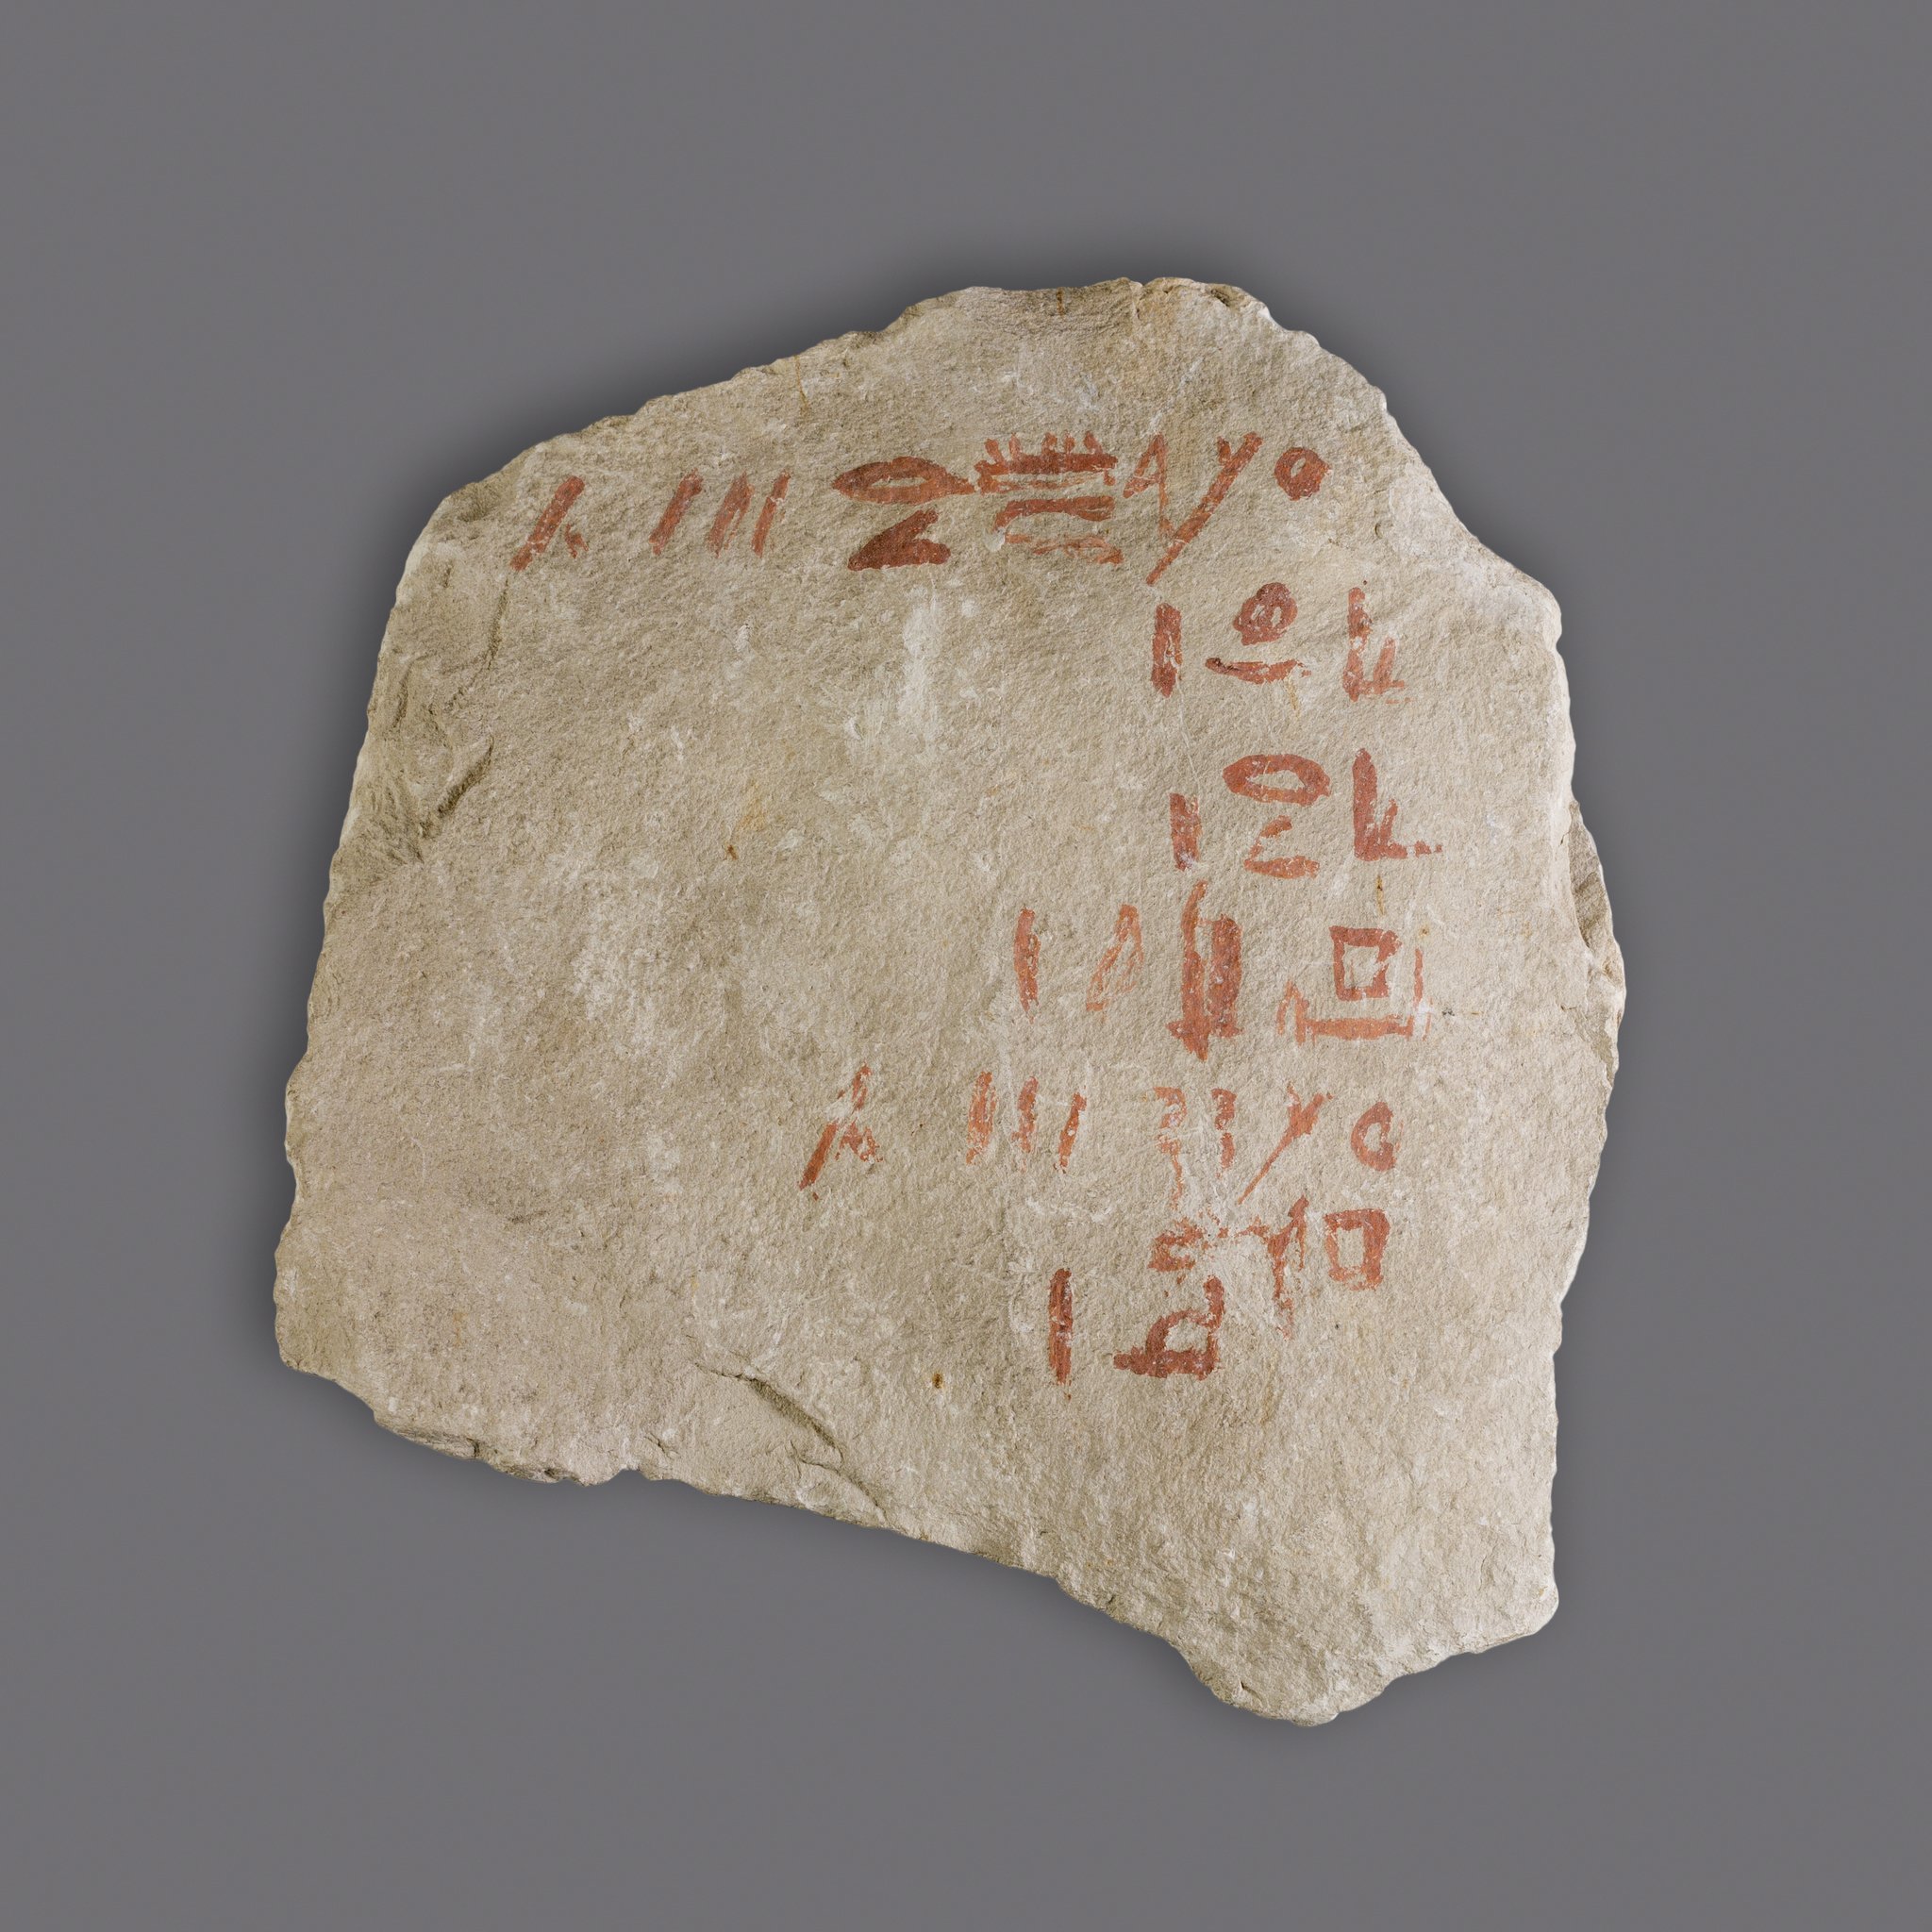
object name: ostracon, hieratic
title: Hieratic Ostracon with accounts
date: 525-404 BCE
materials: ink, limestone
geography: egypt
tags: hieroglyphs